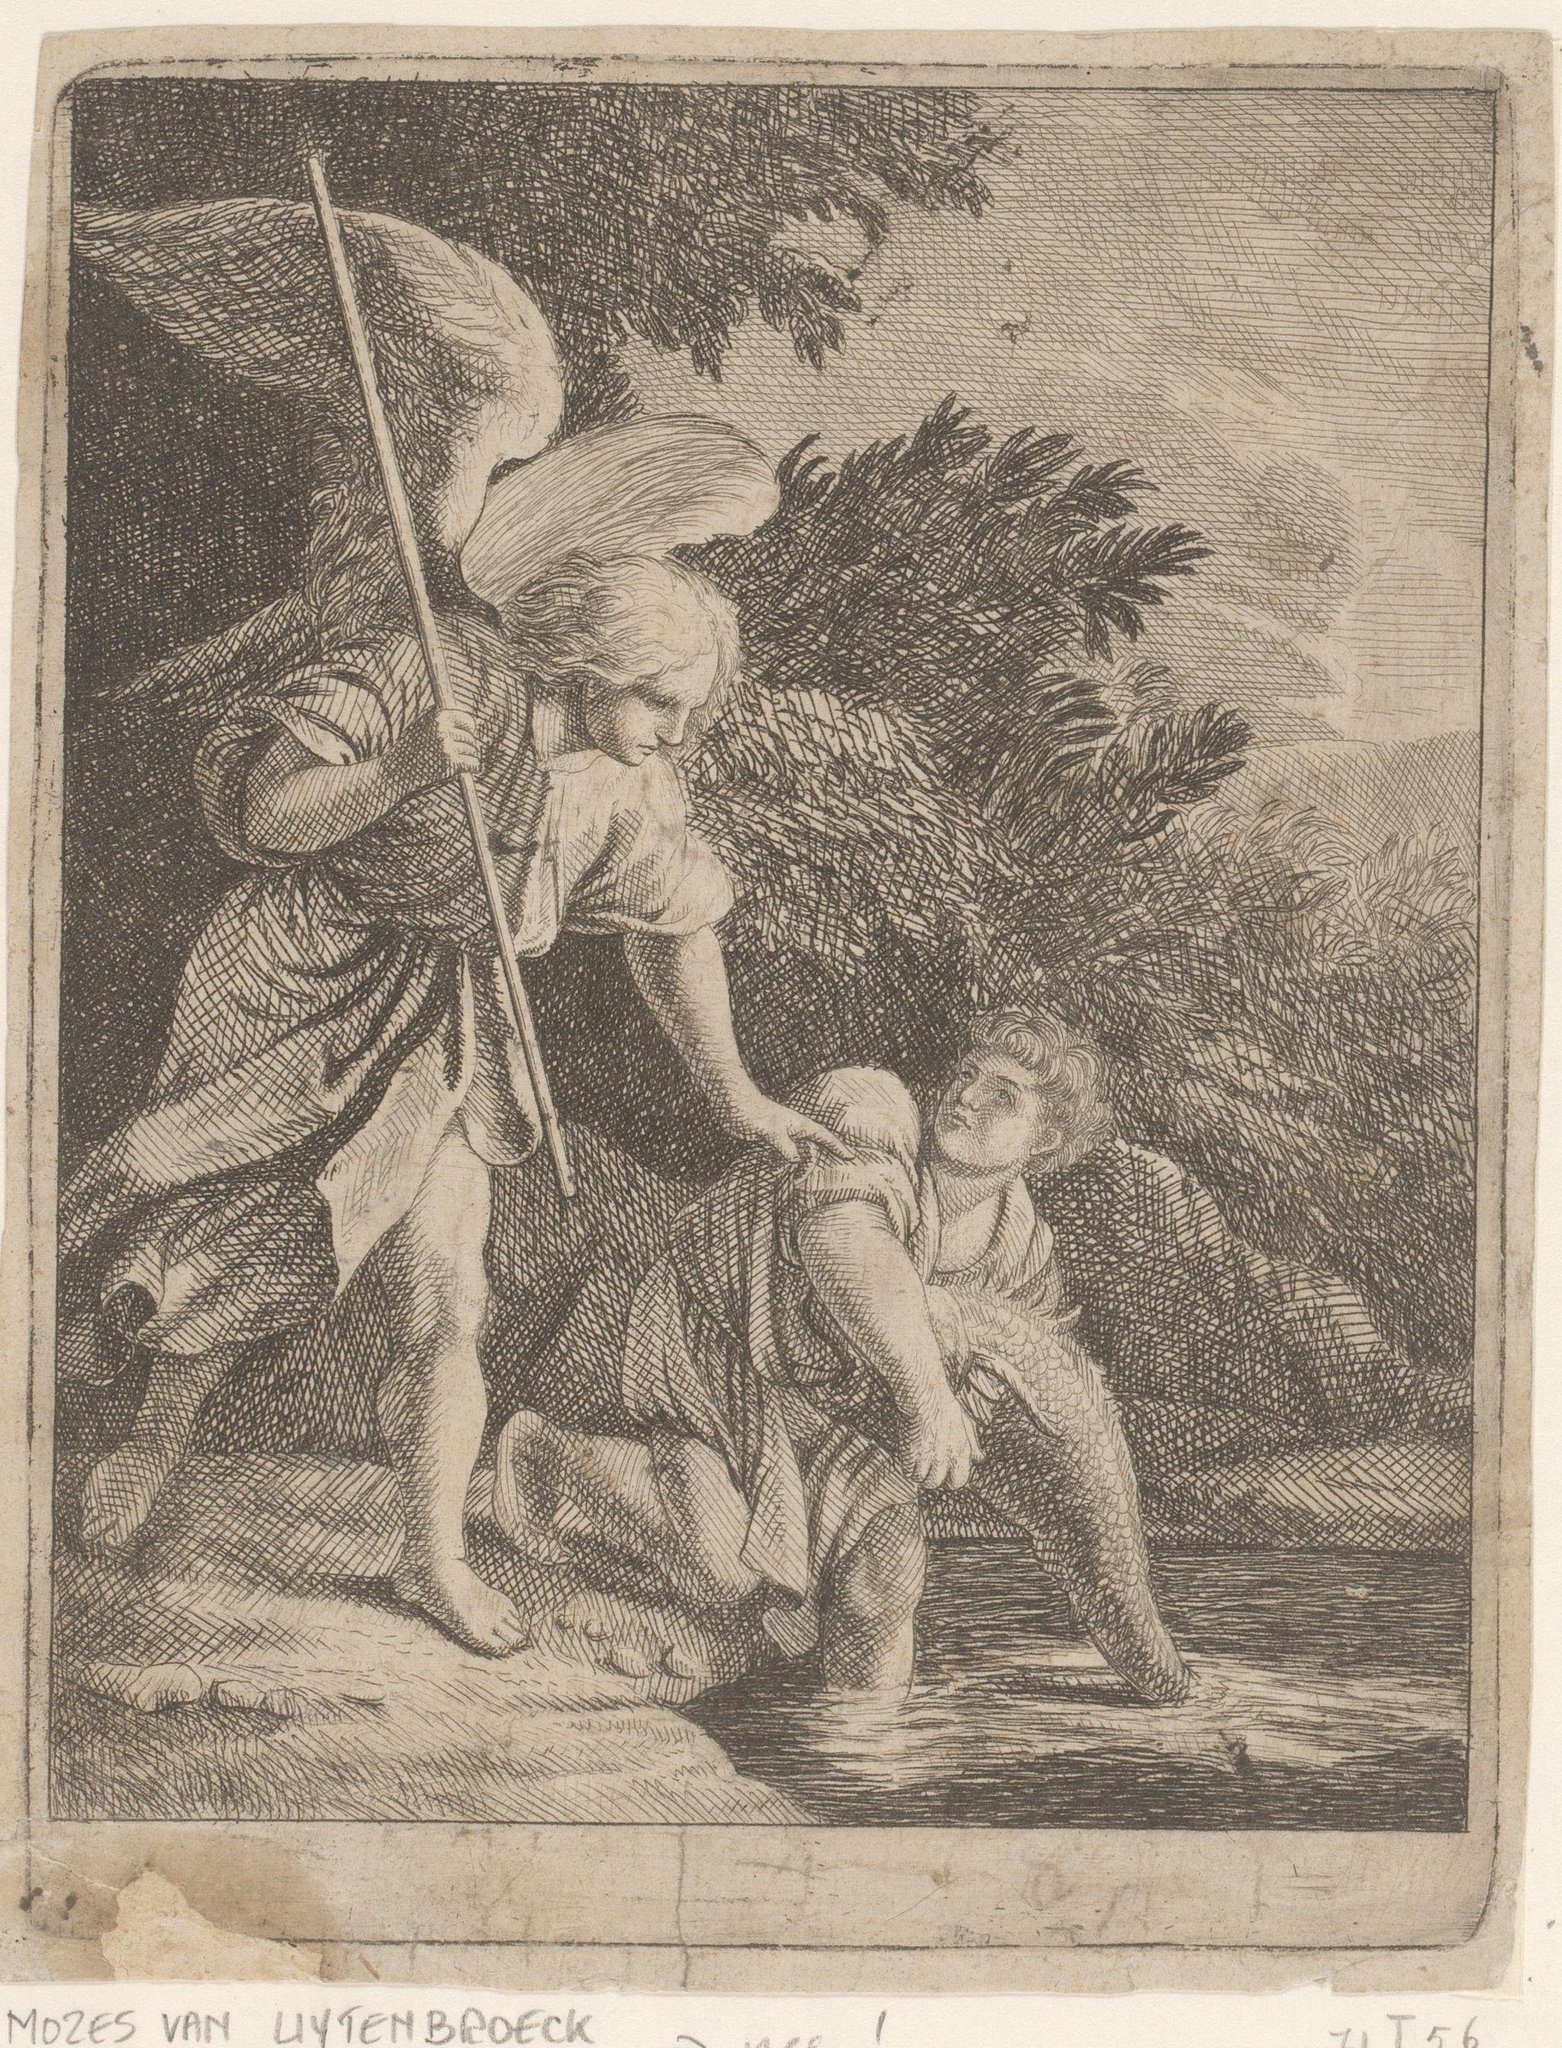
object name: print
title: Tobias en de vis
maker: claude duvivier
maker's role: silversmith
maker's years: 1688-1747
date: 1600-1749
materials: paper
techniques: etching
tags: tobias captures the fish and pulls it on the land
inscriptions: inscription: ‘[...] Duvivier’, collector's mark: Lugt 2228